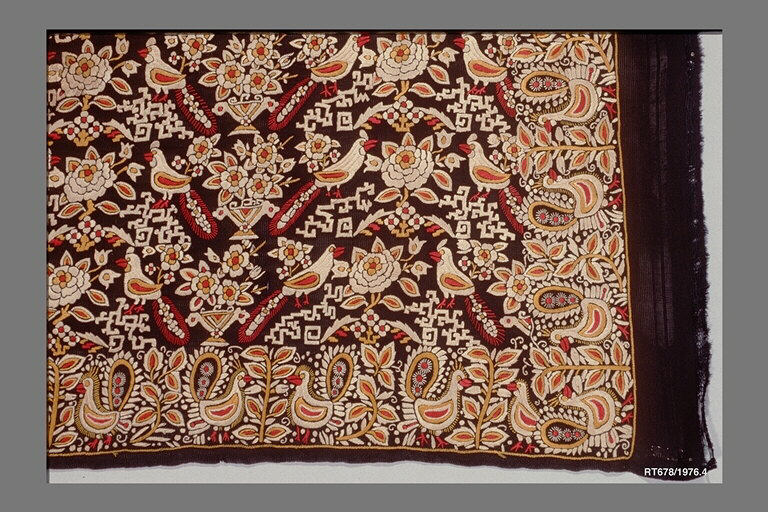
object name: sari, silk gauze, portion of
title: Portion of Silk Gauze Sari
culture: chinese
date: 1801-1900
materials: silk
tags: birds,flowers,leaves